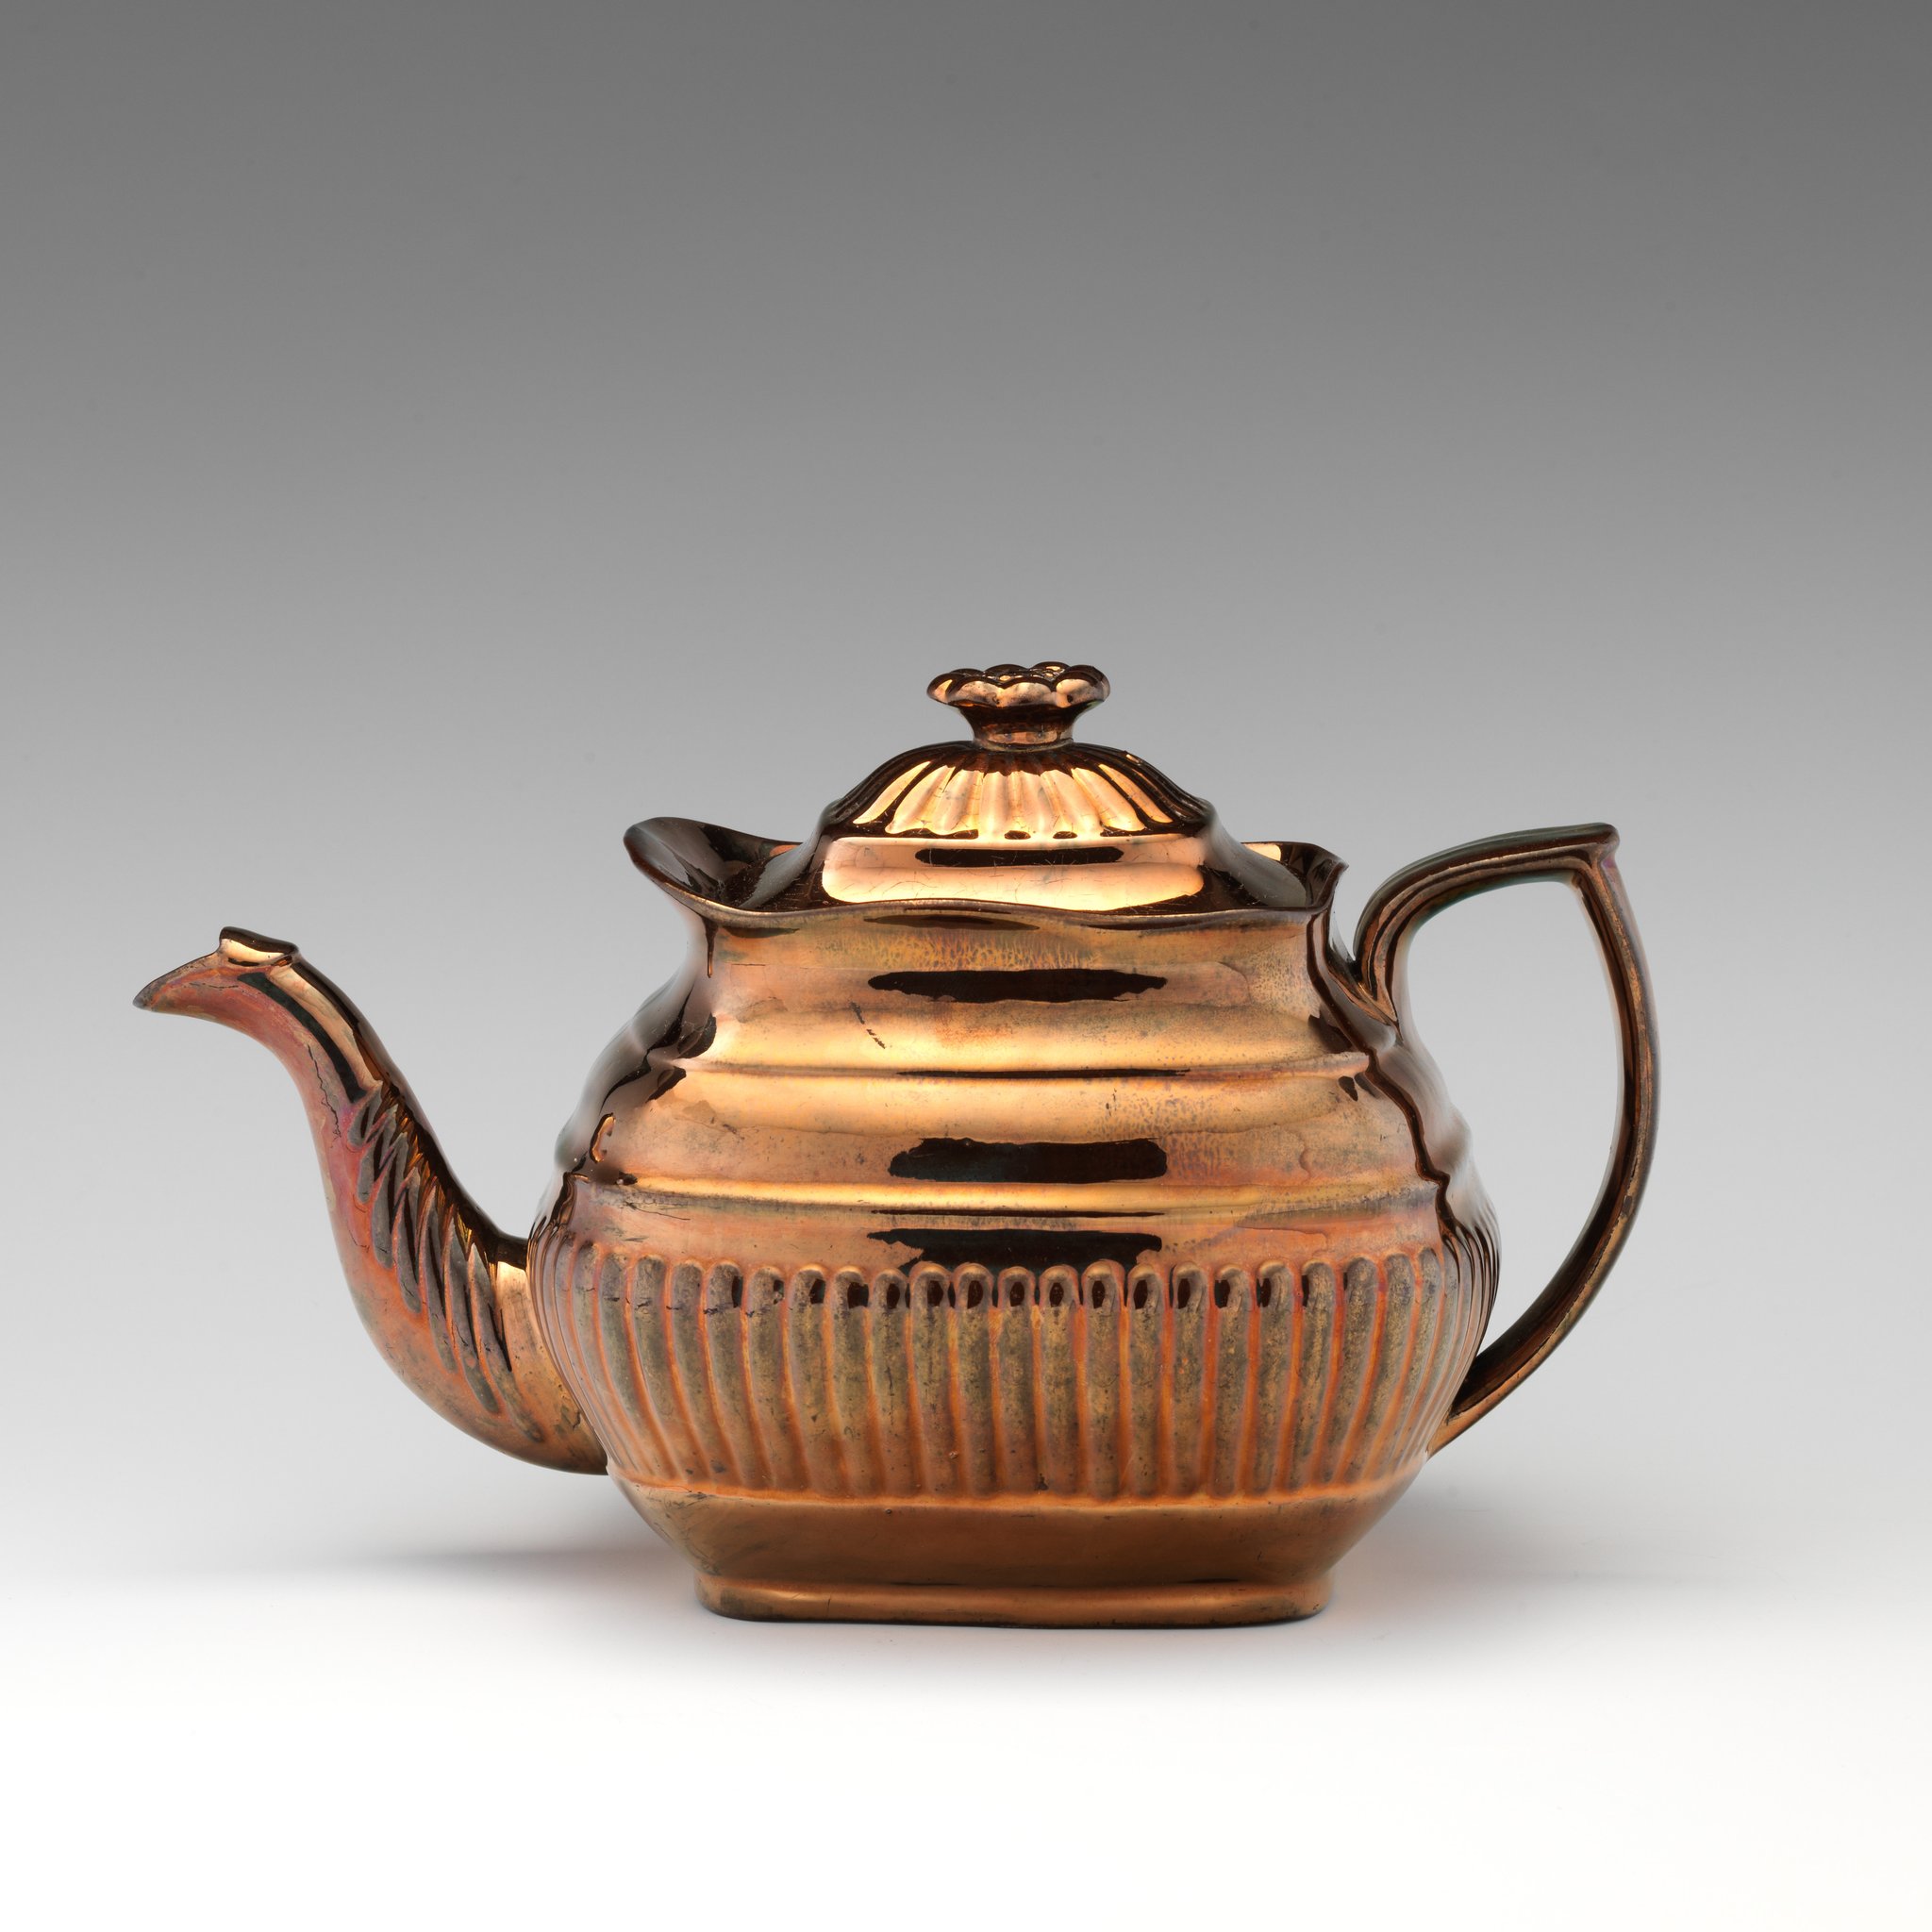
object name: teapot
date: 1801-1833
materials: pottery